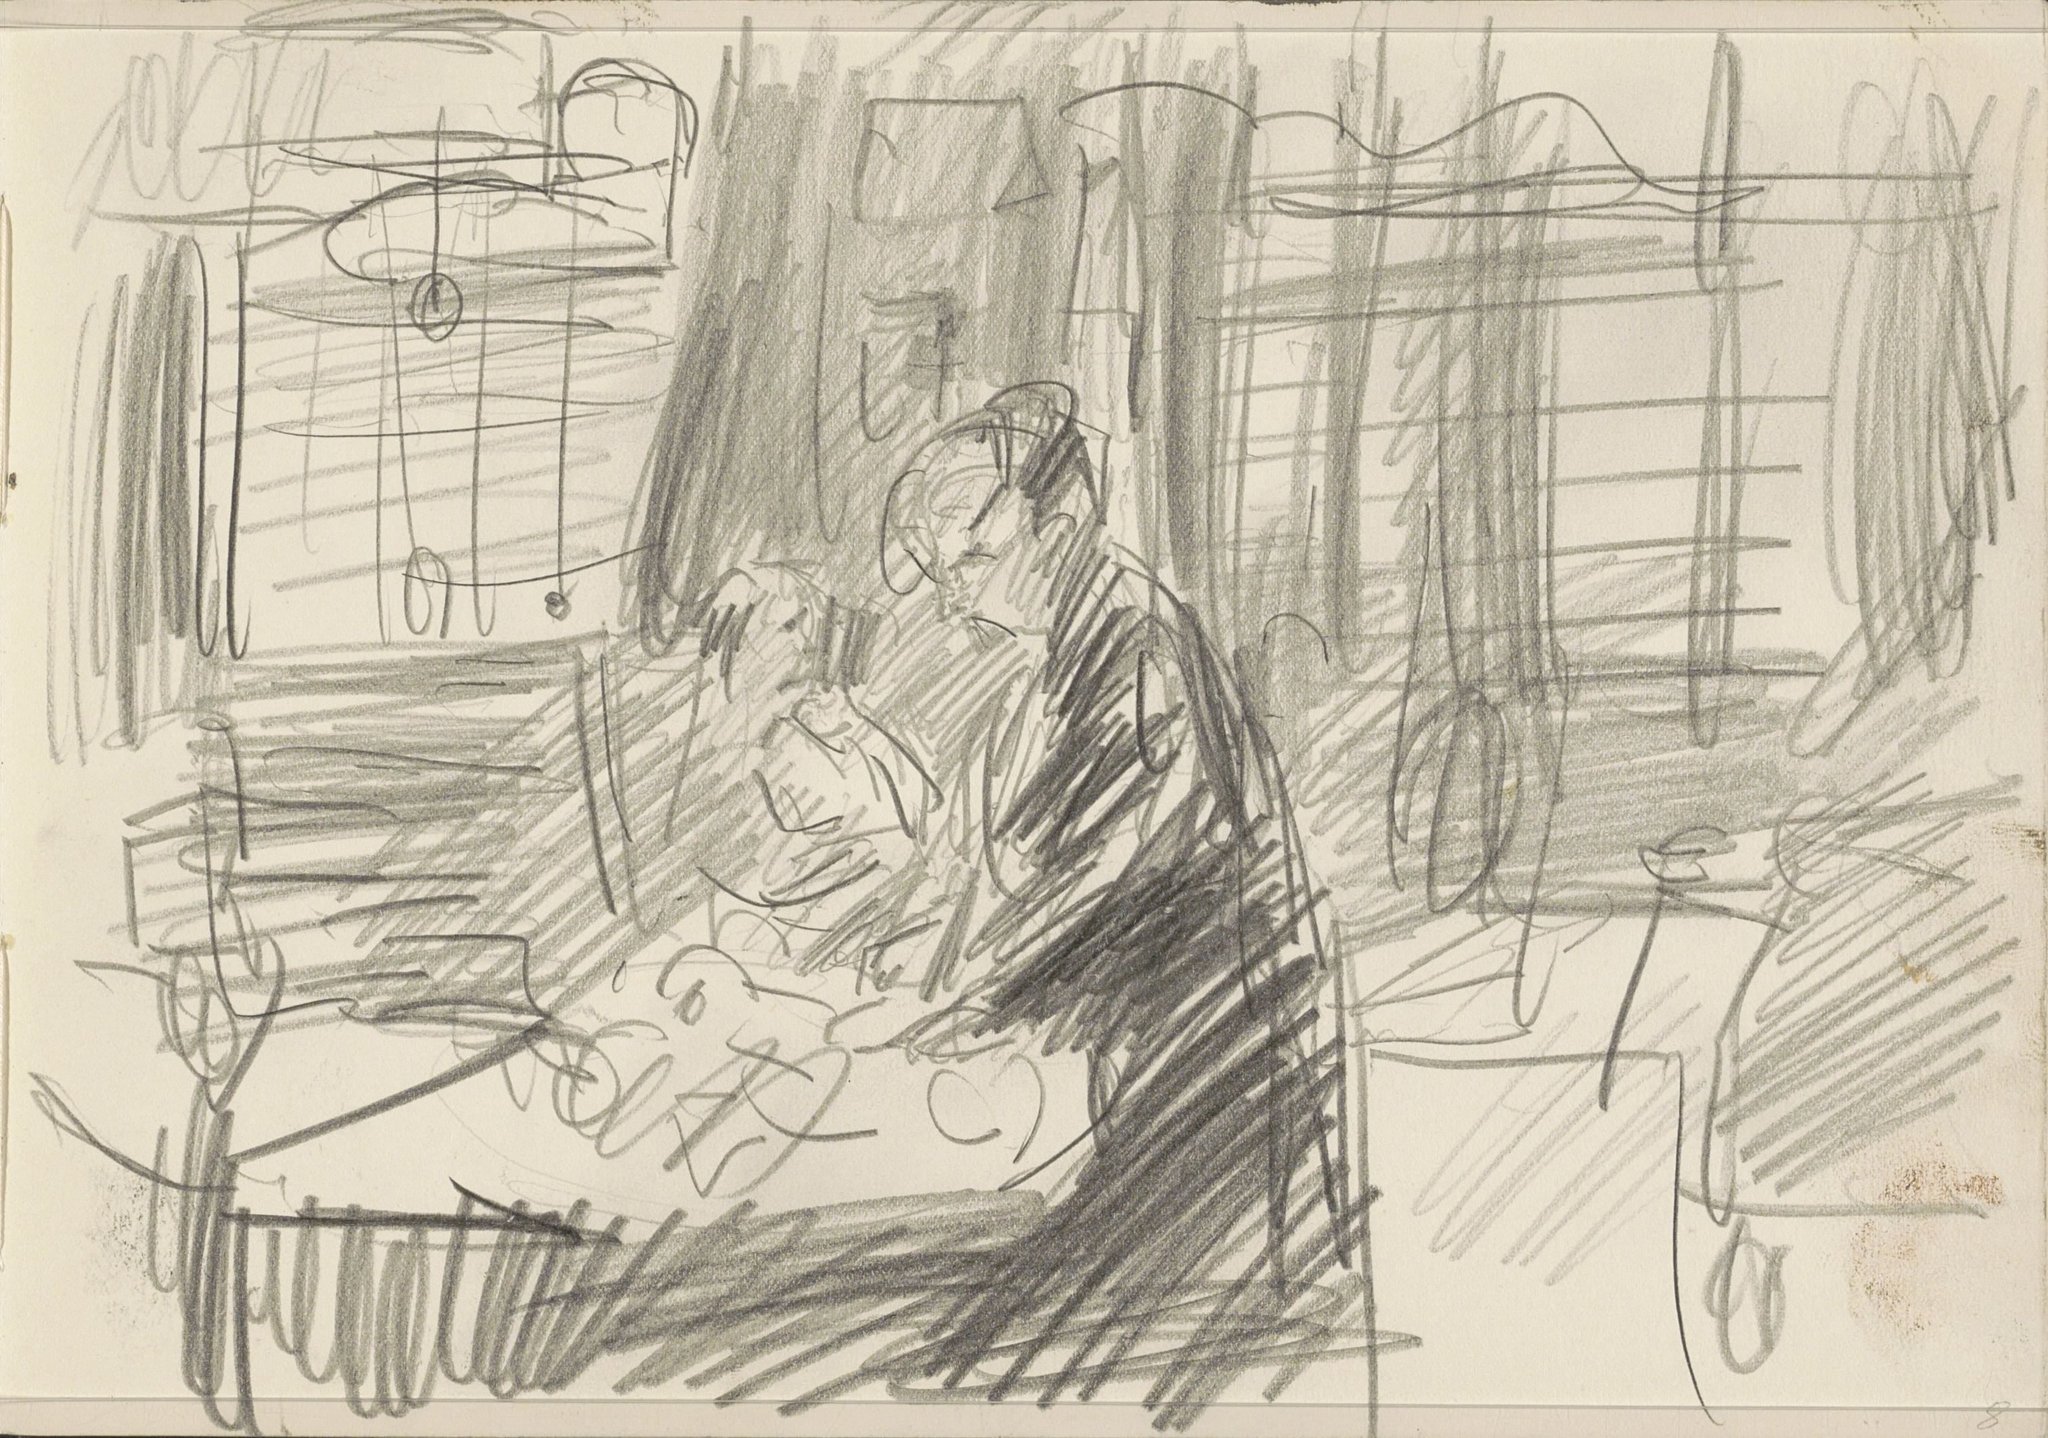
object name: sketchbook leaf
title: Figuren in een interieur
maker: isaac israels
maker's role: draughtsman, painter, print maker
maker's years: 1865-1934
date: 1930-1934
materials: paper, pencil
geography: the hague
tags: the (nude) human figure; 'corpo humano' (ripa), interior of the house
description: Blad 8 recto uit schetsboek I met 26 bladen.